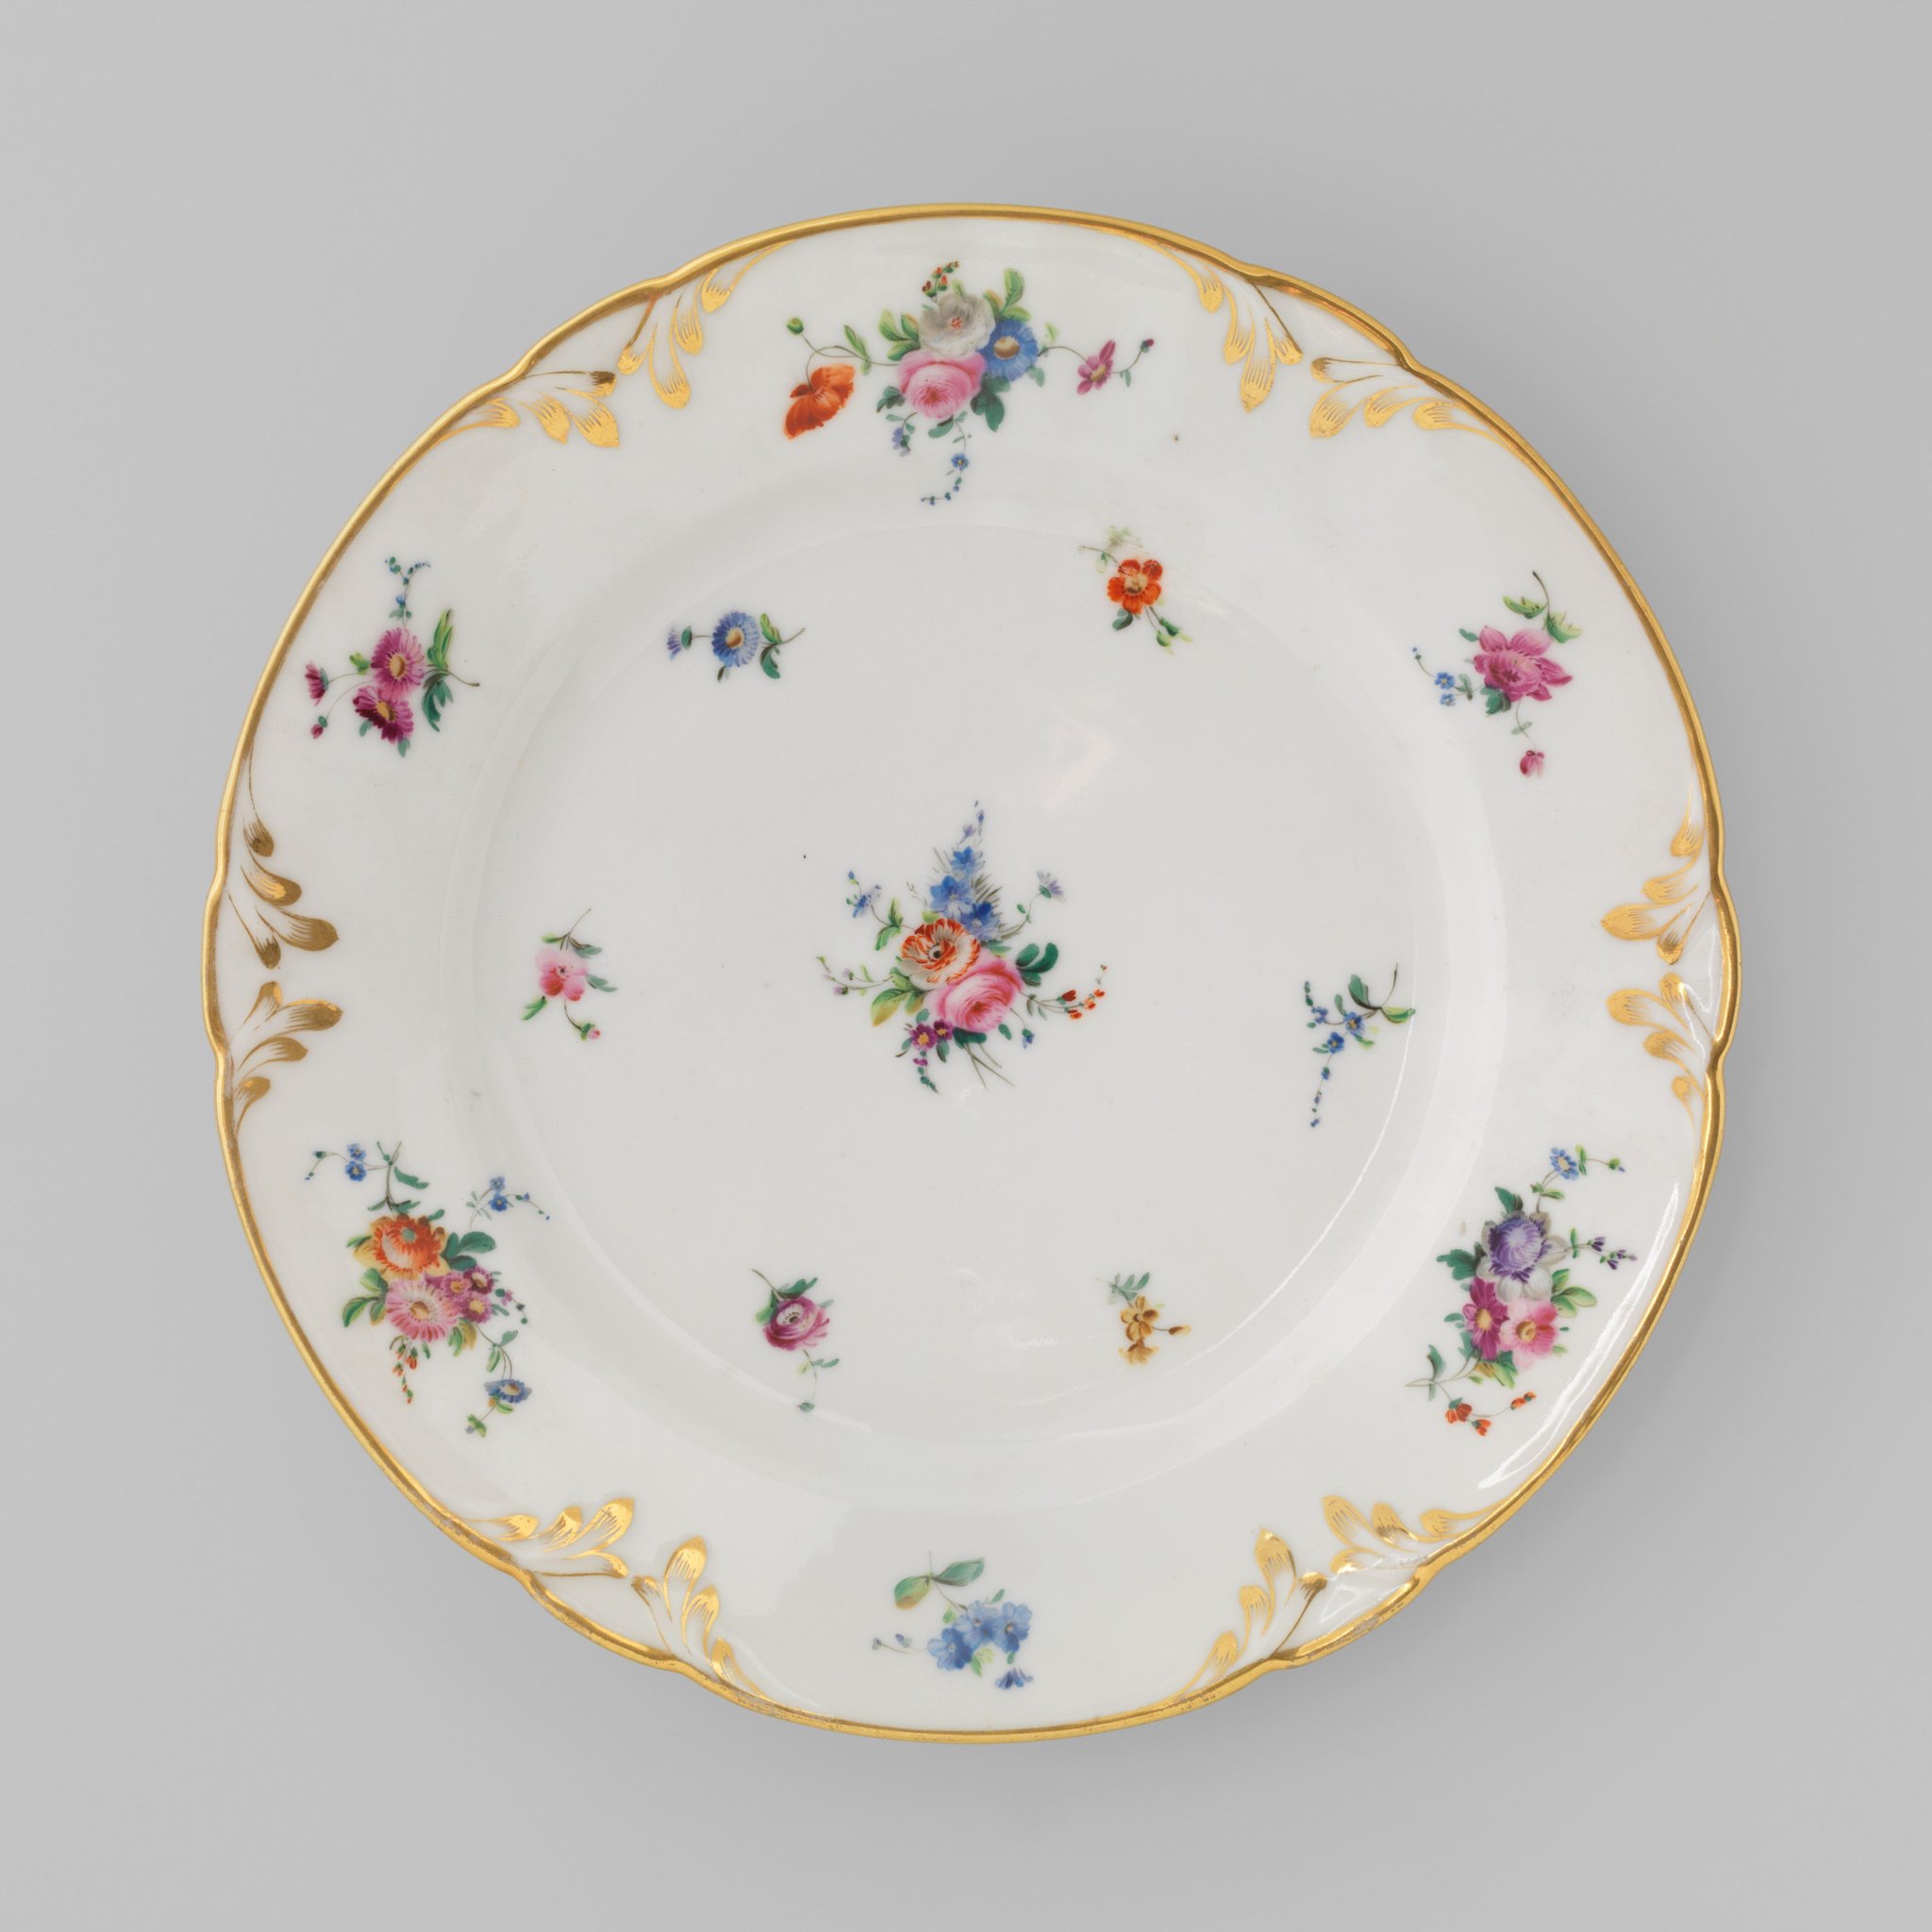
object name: service set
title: Plate with bouquets and flower sprays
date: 1839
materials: glaze, gold, paint, porcelain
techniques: firing, forming, gilding, turning, vitrification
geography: paris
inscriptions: mark: ‘DENUELLE/ Boulevard St. Denis 18/ à Paris’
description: Bord (dessertbord) van porselein met een gelobde rand, beschilderd op het glazuur in blauw, rood, roze, groen, geel, paars, zwart en goud. Op het plat boeketten van verschillende bloemen en strooibloemen. Vanuit de gelobde, gouden rand, gemodelleerde bladranken in reliëf, aangezet met goud. Hiertussen boeketten. Drie proenen op de onderzijde. Gemerkt op de onderzijde met 'DENUELLE/ Boulevard St. Denis 18/ à Paris'.